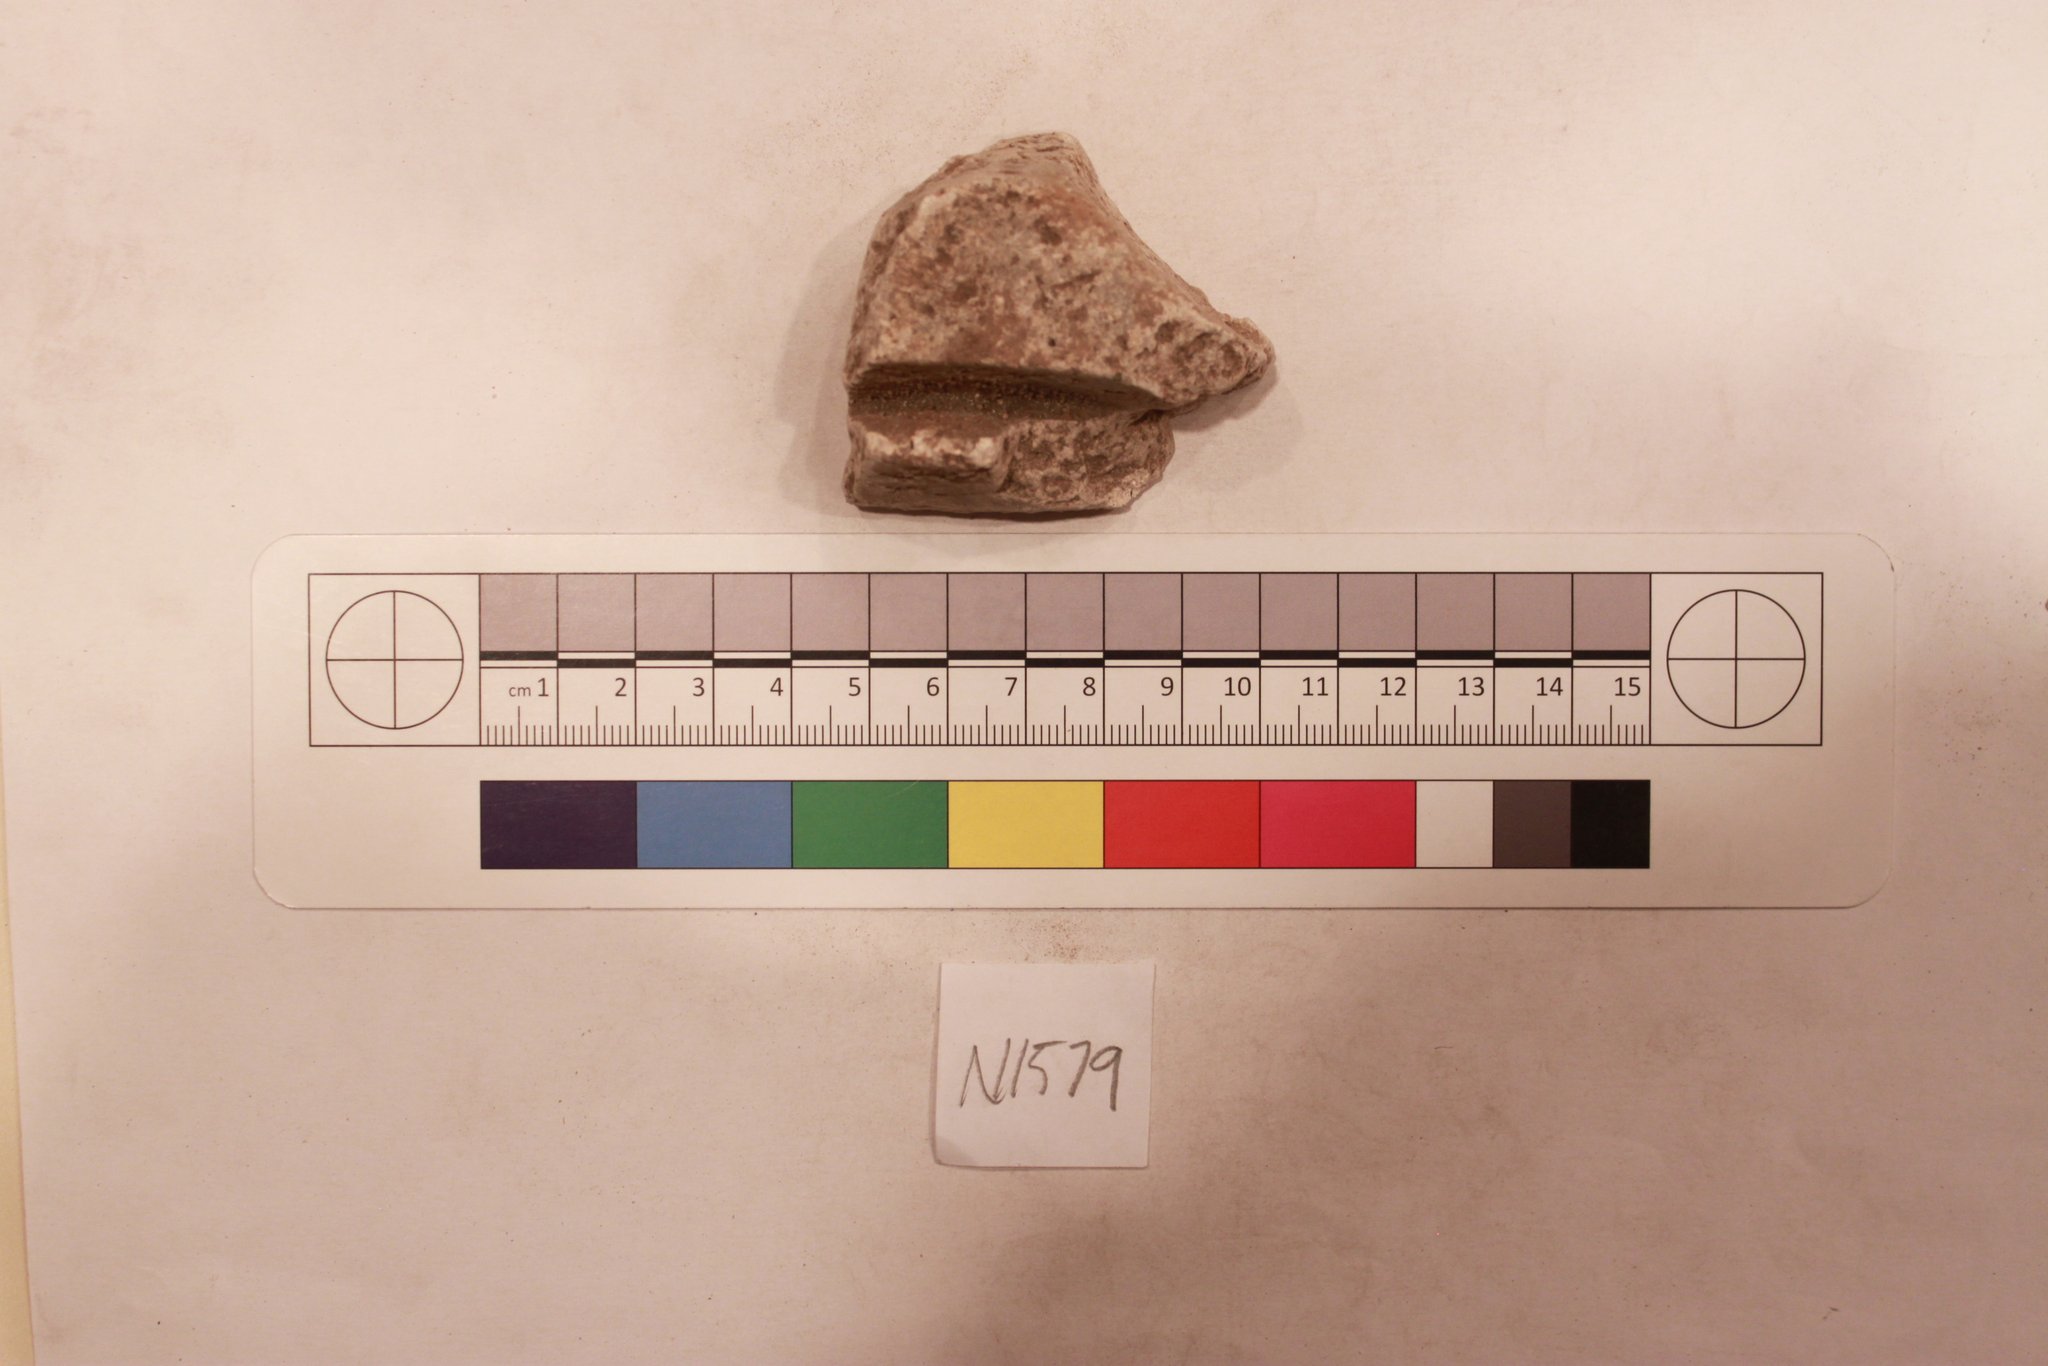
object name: fragment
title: Stucco Fragment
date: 701-1200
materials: plaster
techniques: carving, painting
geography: iran